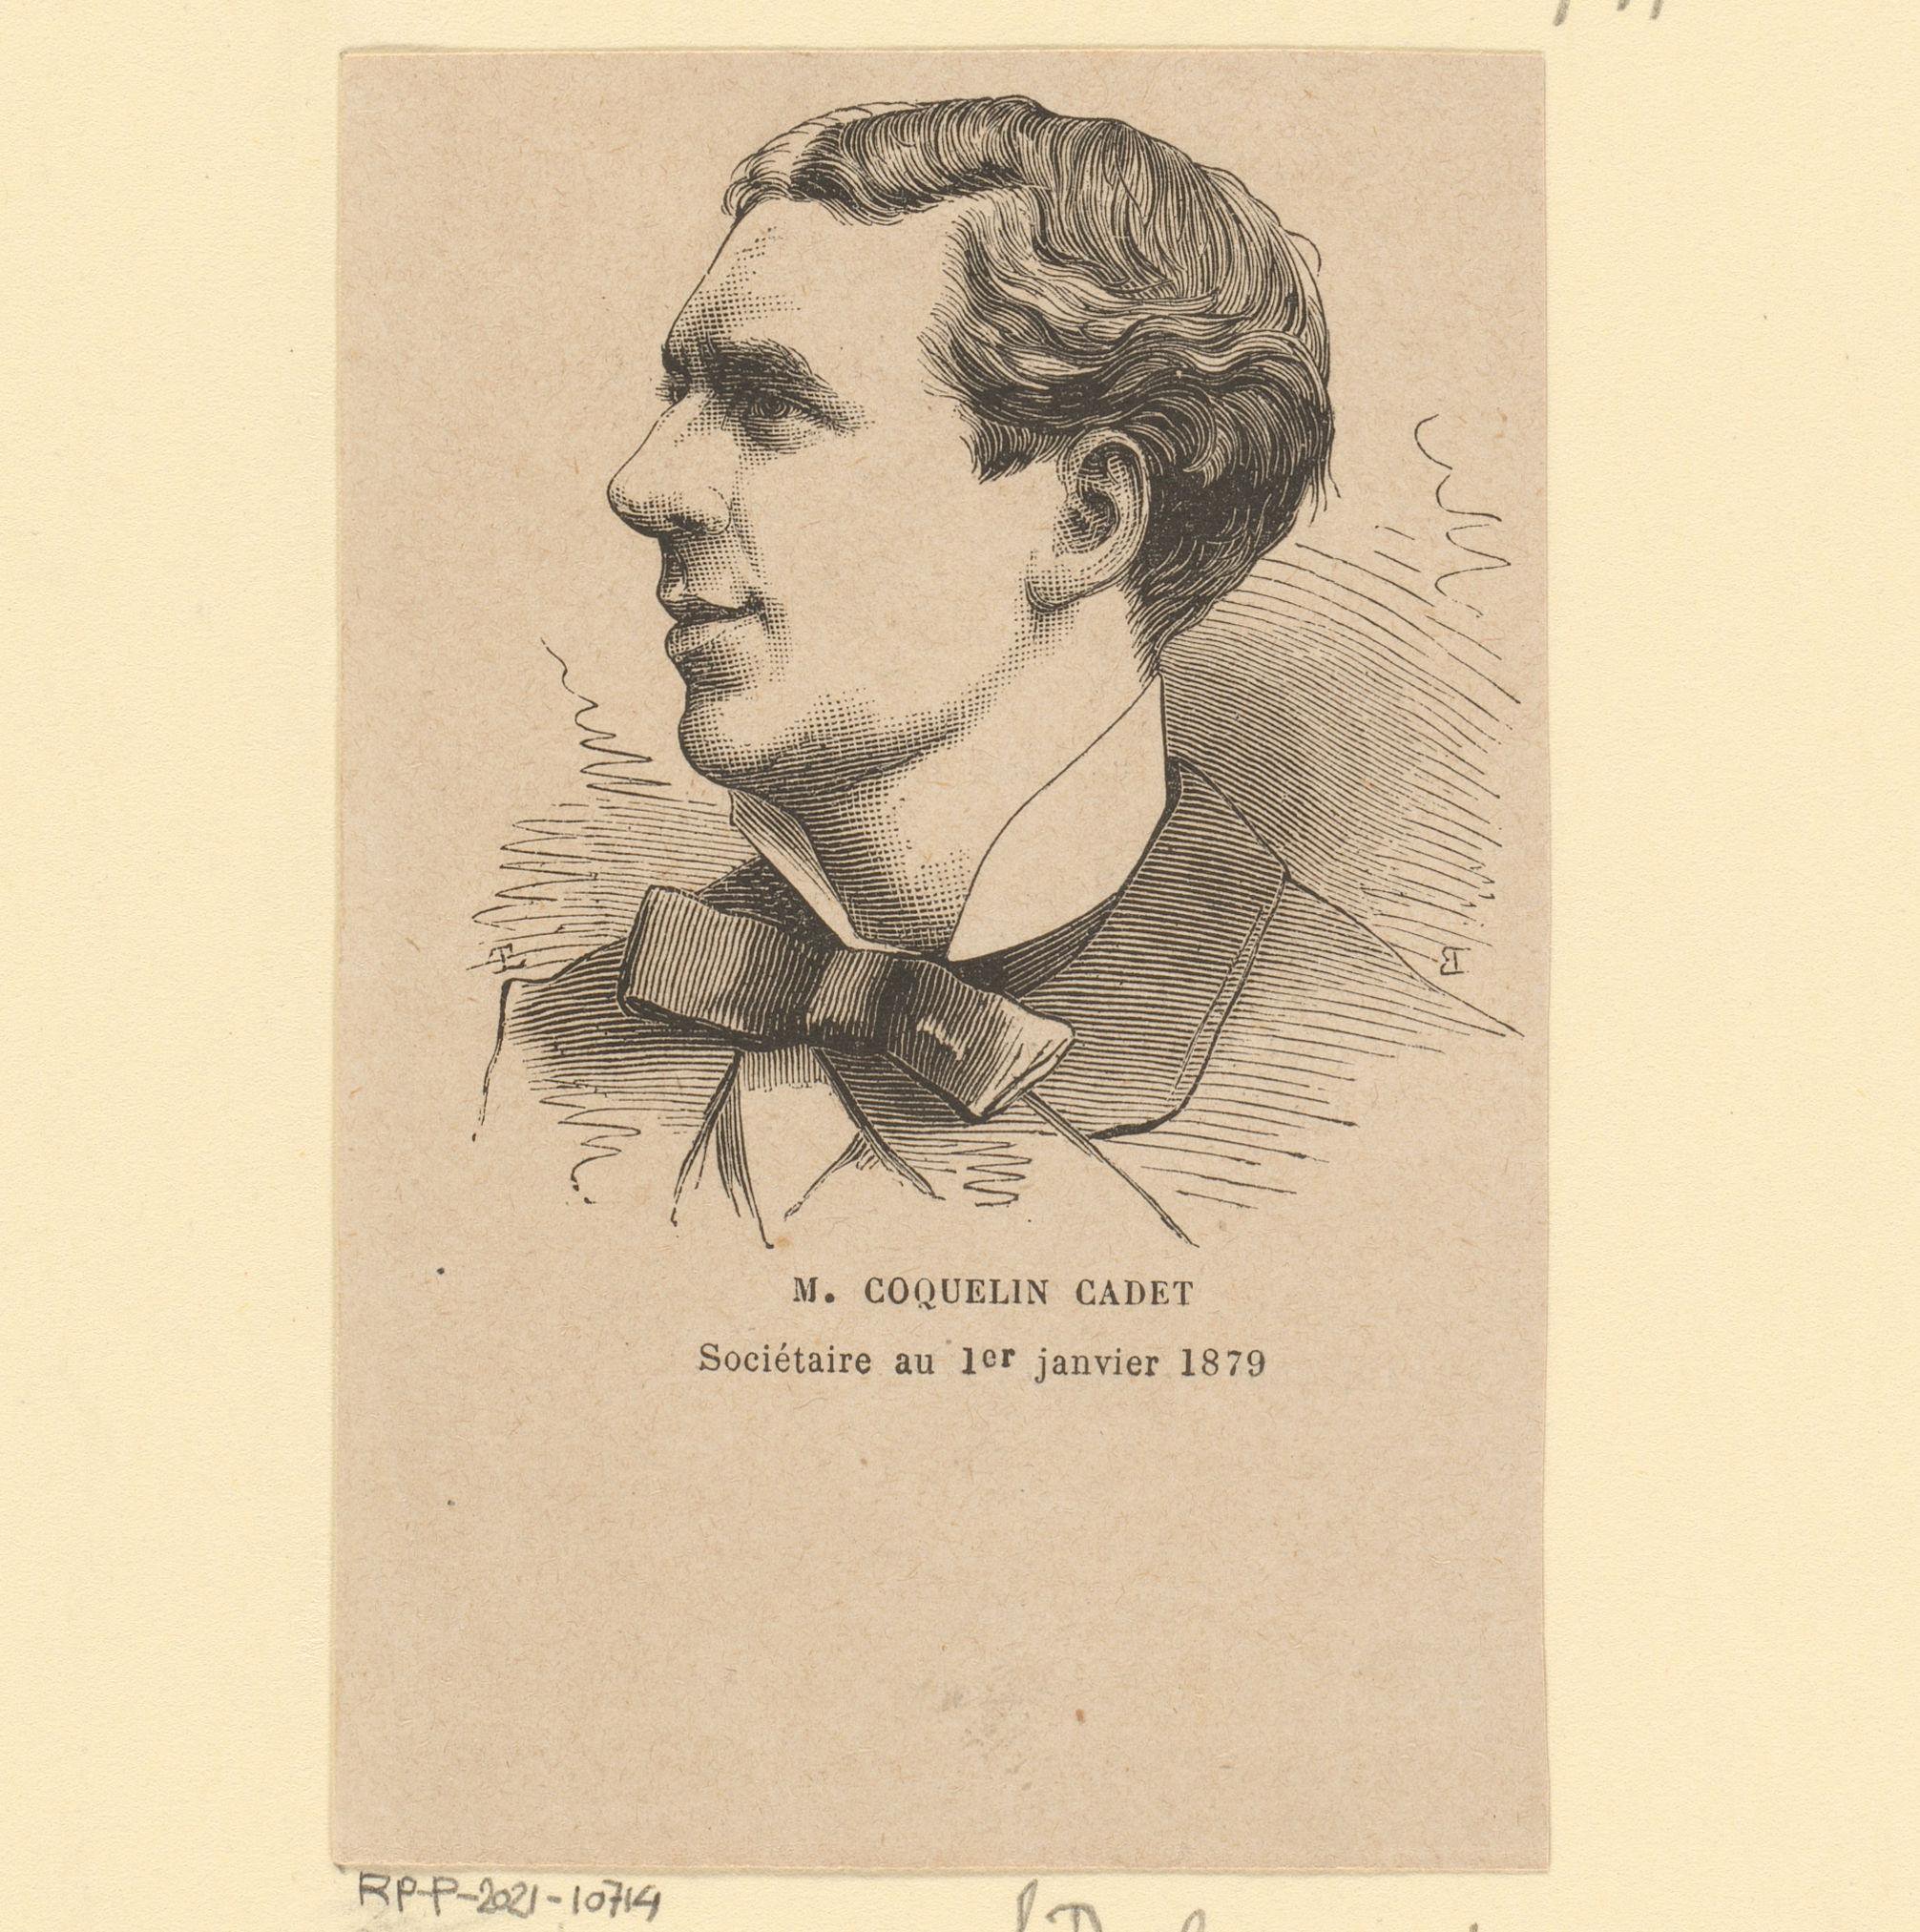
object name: print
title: Portret van Ernest Alexandre Honoré Coquelin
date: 1879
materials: paper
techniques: letterpress printing, engraving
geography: paris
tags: historical persons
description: Prent uit: Le monde illustré: journal hebdomadaire 23 (1879), nr. 1168, 16 augustus 1879.